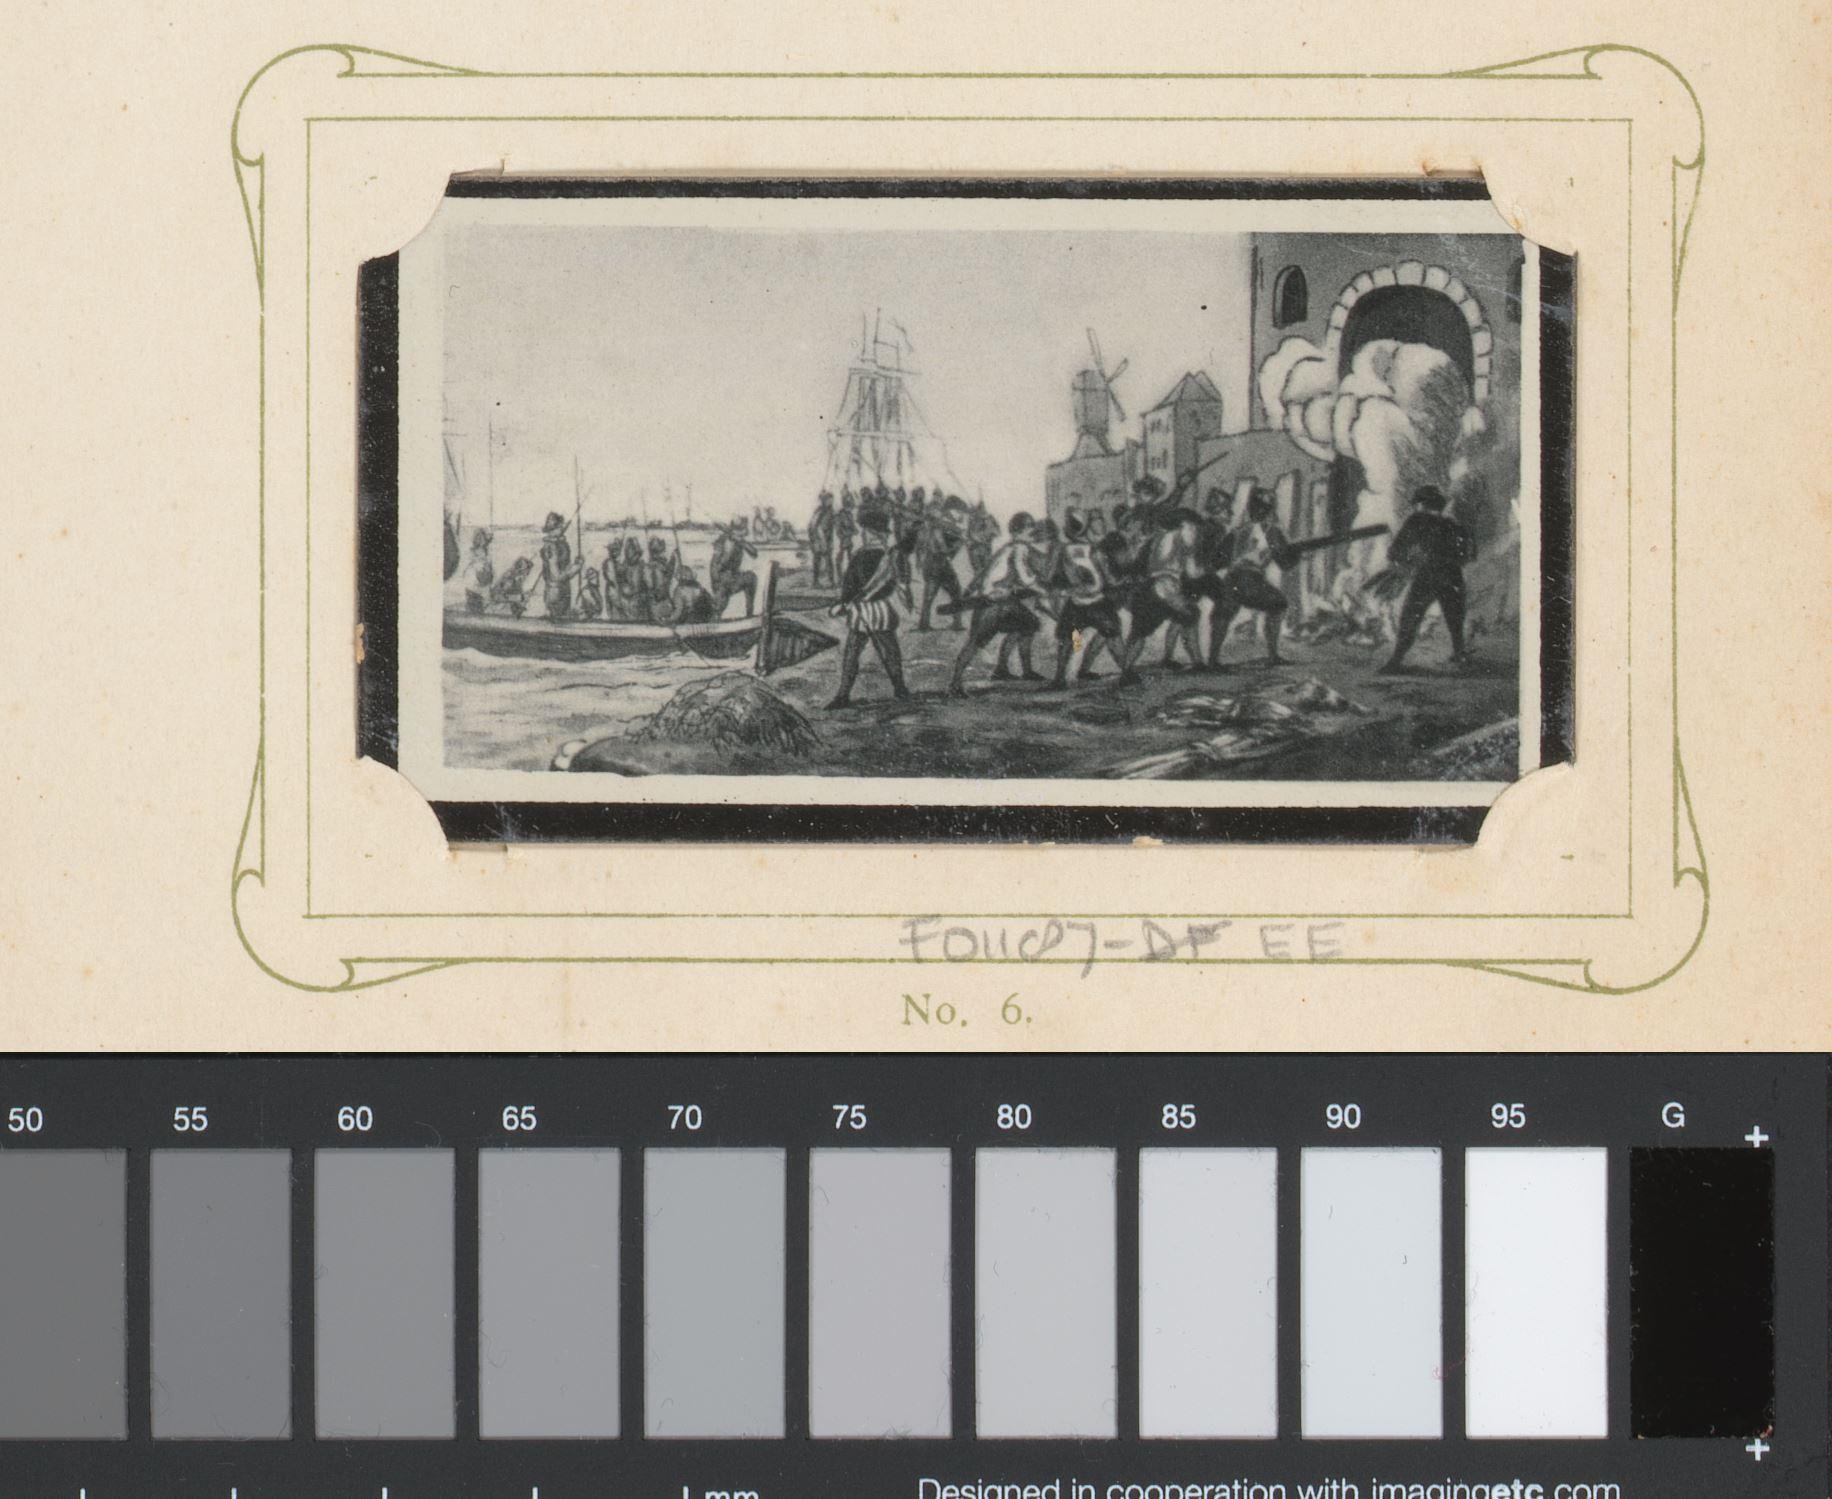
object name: photomechanical print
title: Reproductie van een tekening van de Inname van Den Briel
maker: Anonymous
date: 1905-1906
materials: paper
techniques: photograph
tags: siege, brielle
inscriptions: inscription: ‘No. 6./ Inneming van den Briel.’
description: Deze prent maakt deel uit van een album.